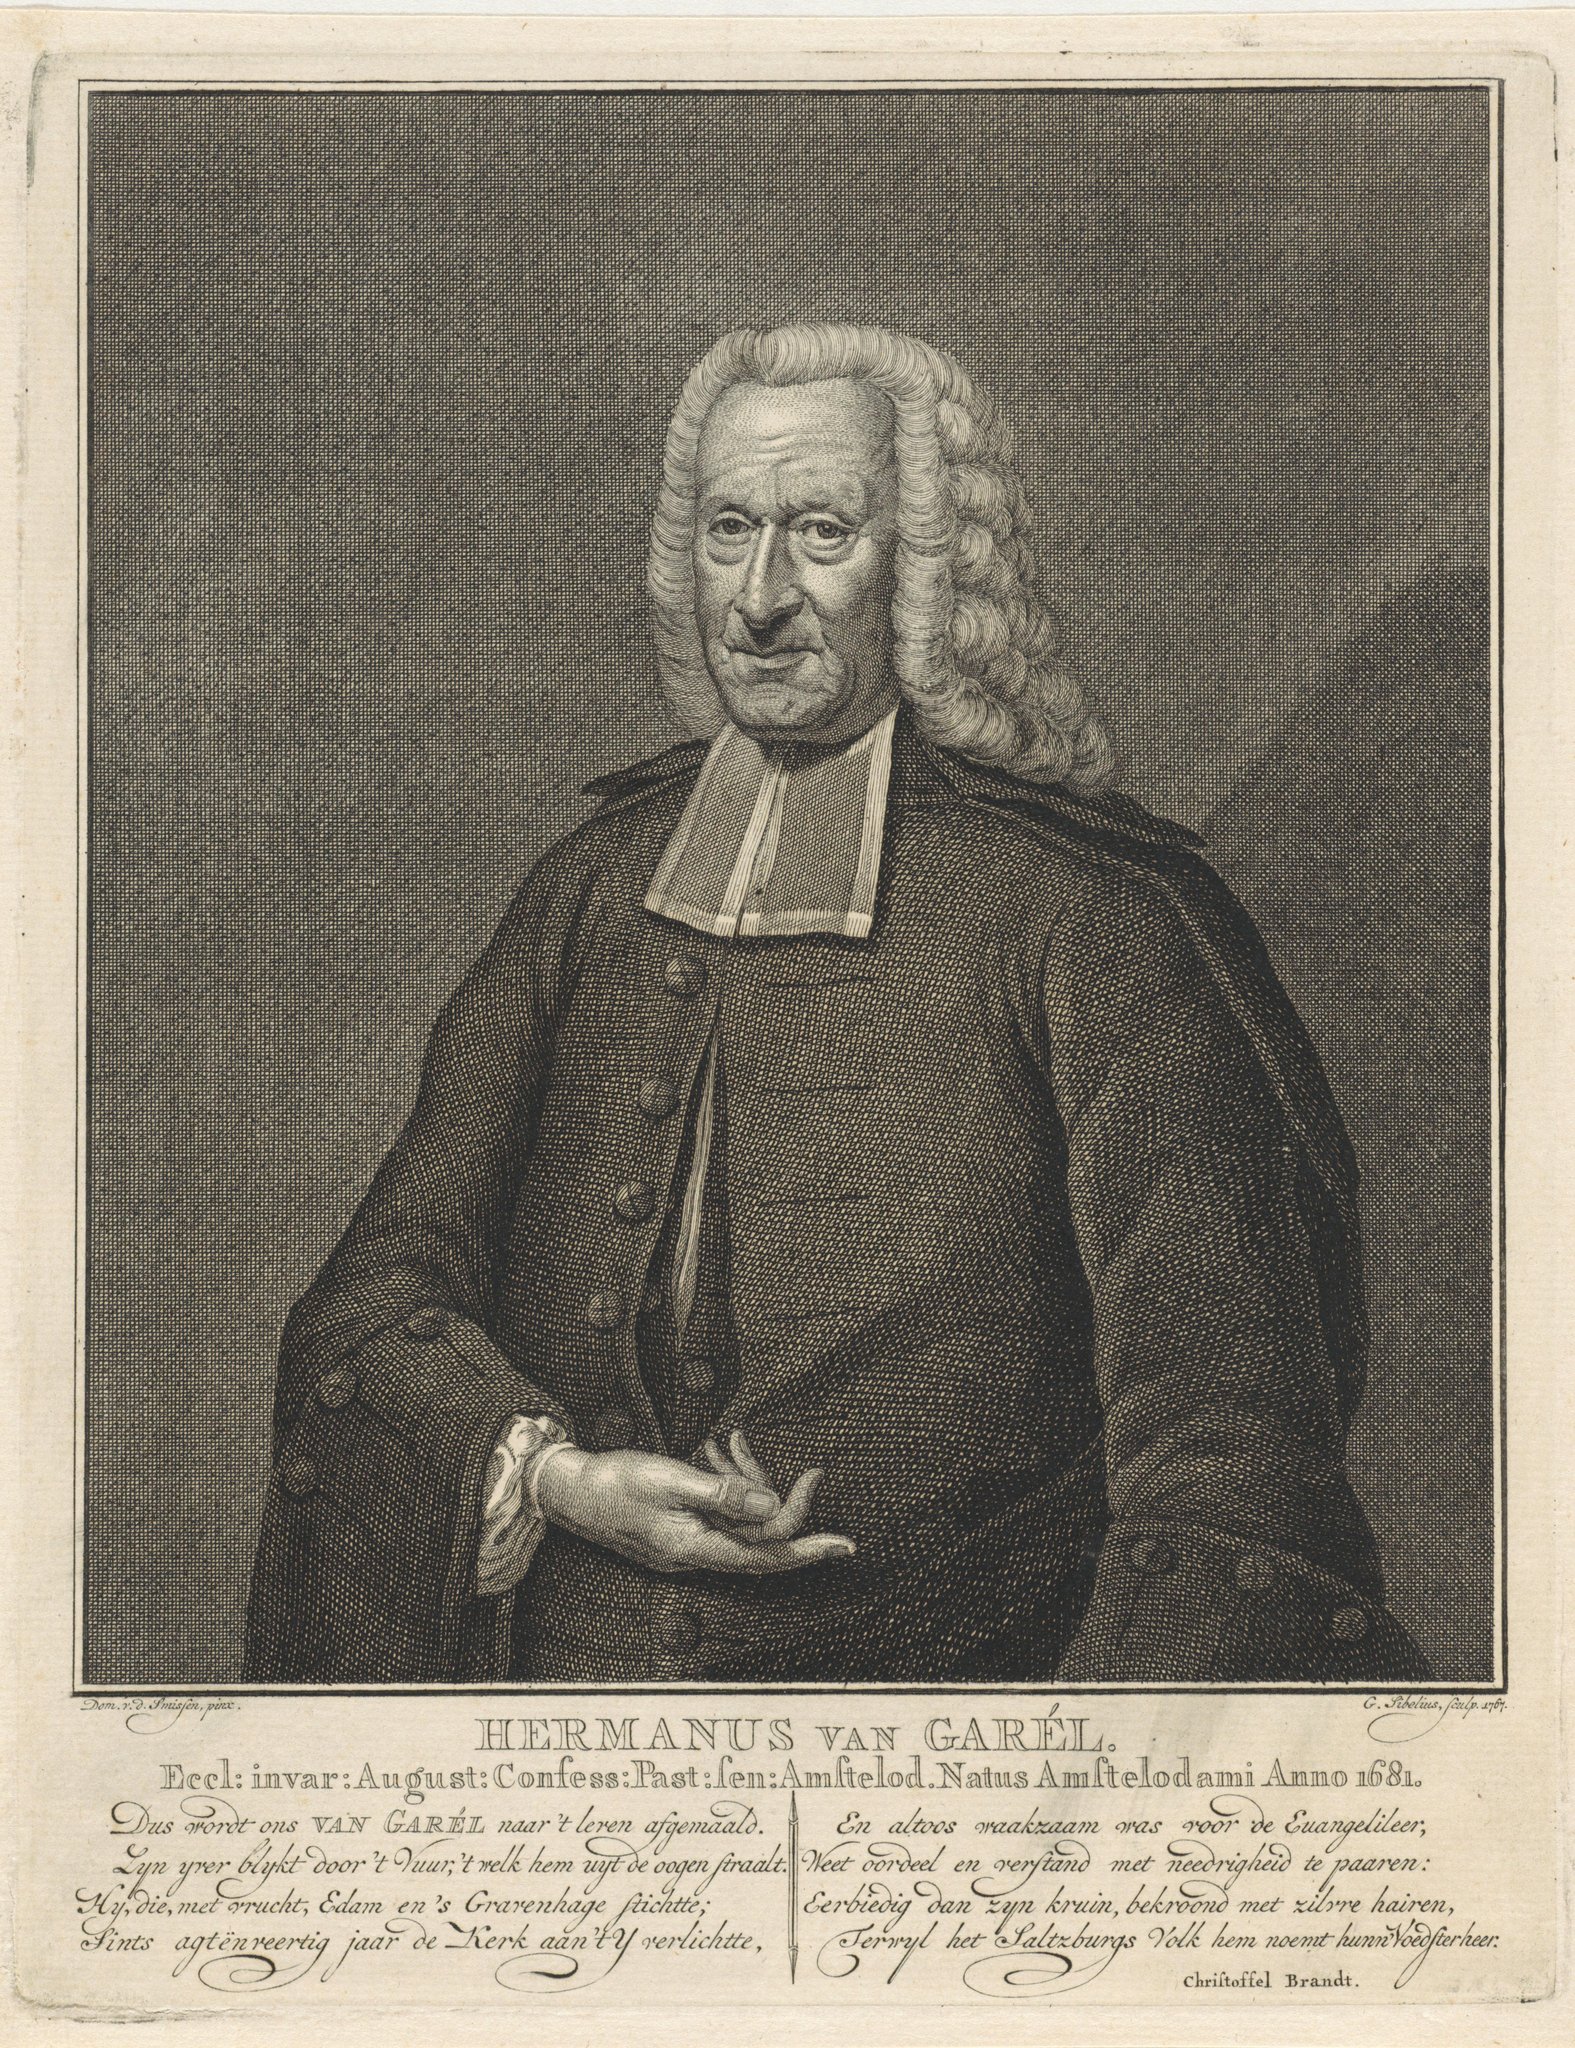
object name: print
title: Portret van Hermanus van Garel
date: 1767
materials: paper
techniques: engraving, etching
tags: predikant, hermanus van garel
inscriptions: date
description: Portret van de Amsterdamse predikant Hermanus van Garel. Onder het portret zijn naam, functie en geboortejaar. Daaronder een lofdicht in het Nederlands.